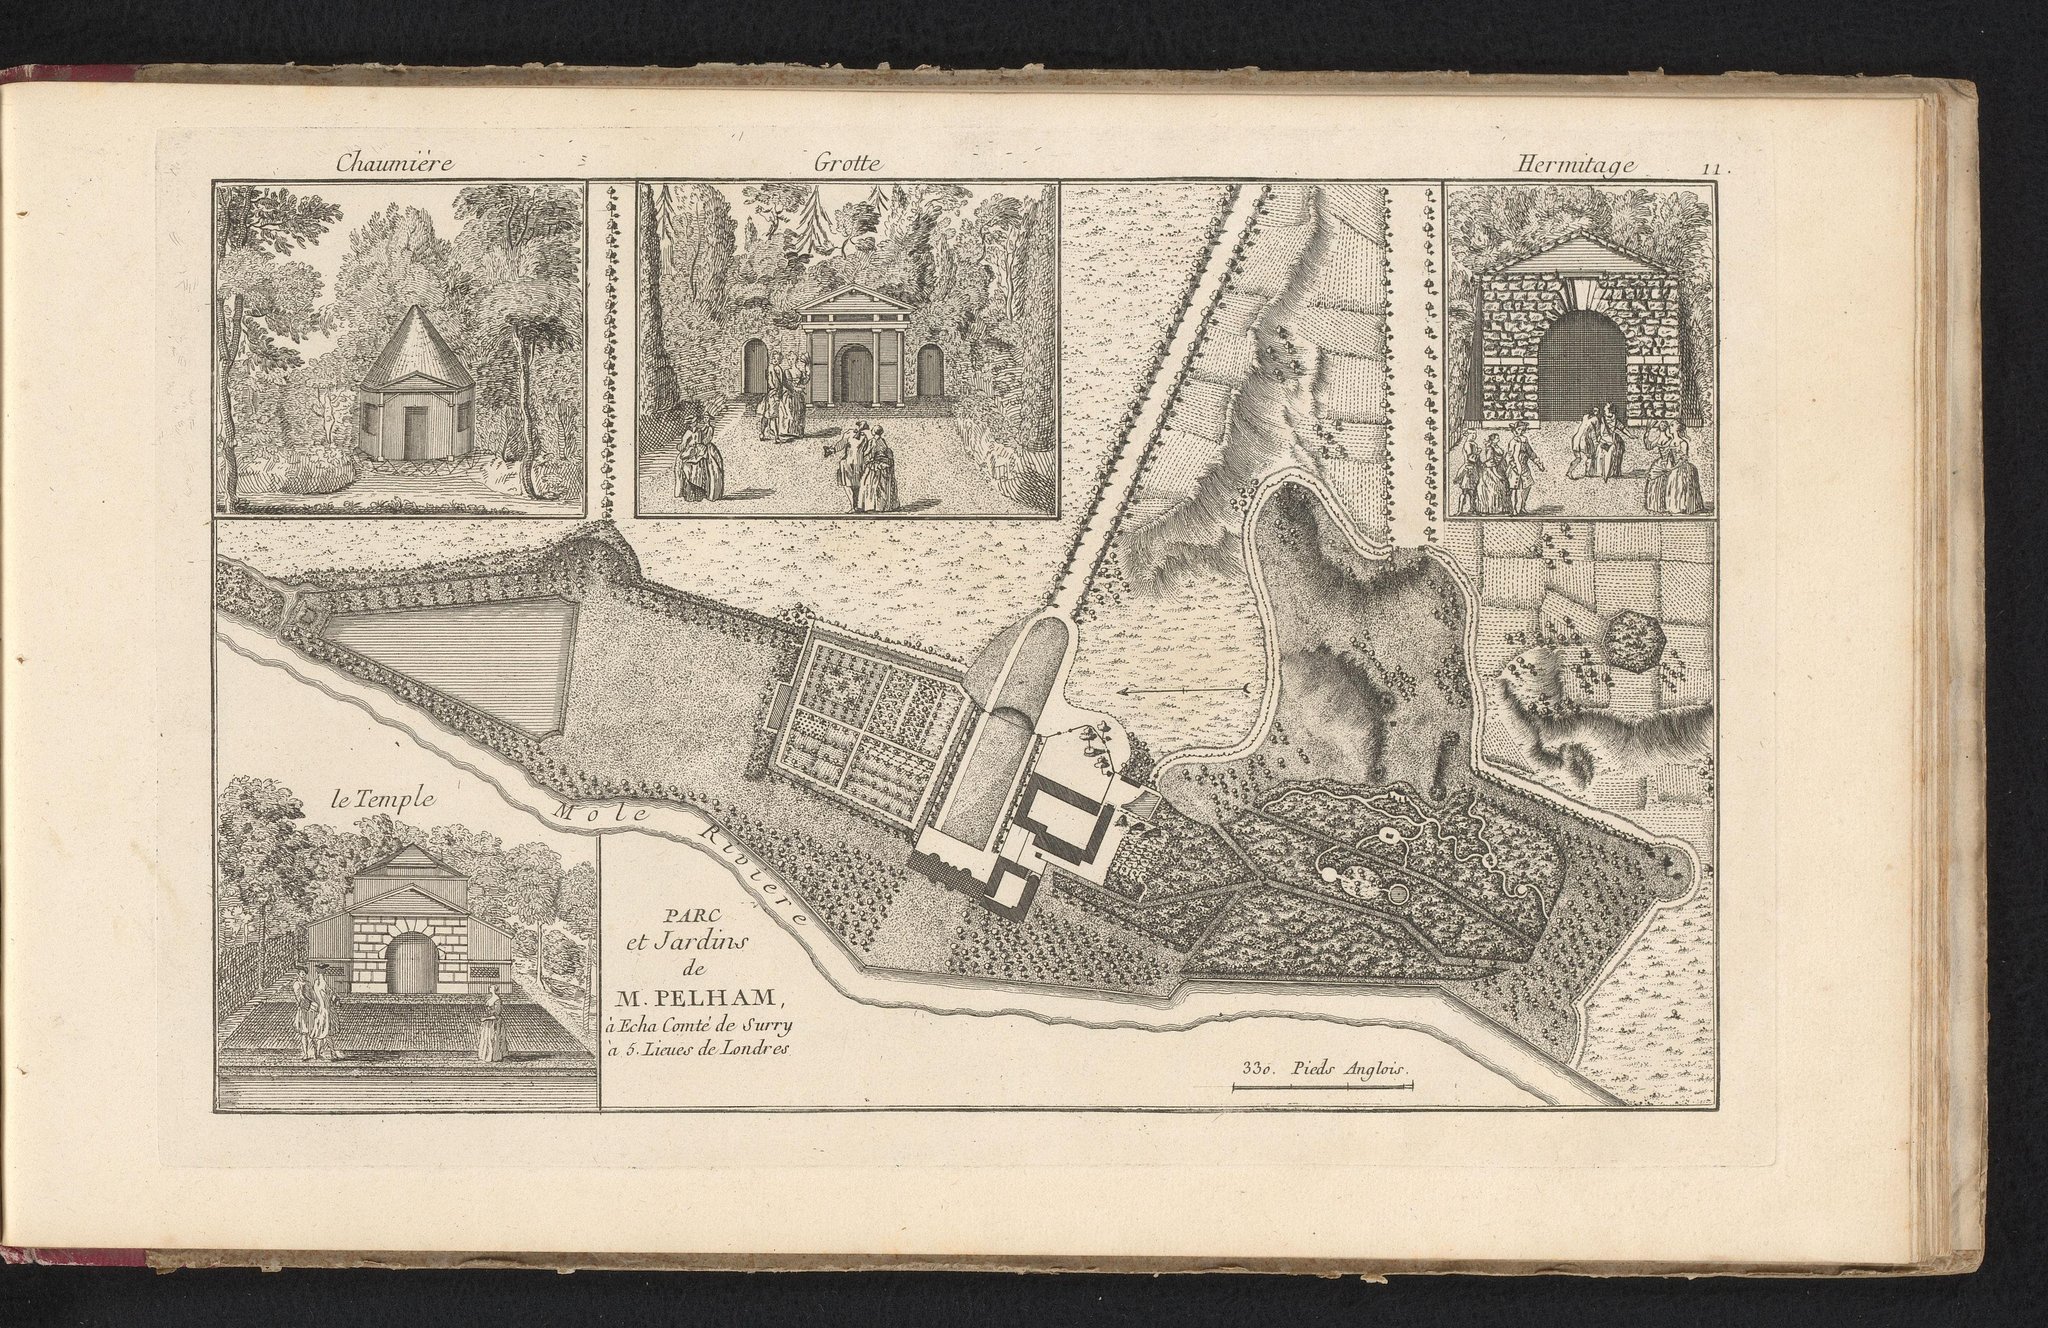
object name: album leaf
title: Plattegrond van de tuin bij Claremont House, met vier kleine gezichten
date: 1775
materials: paper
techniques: engraving, etching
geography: paris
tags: plan, map of garden, garden buildings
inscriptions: collector's mark: Lugt 2228, collector's mark: Lugt 2760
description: De serie 'Jardins anglo-chinois à la mode' verscheen in totaal in 21 zogeheten 'cahiers' (afleveringen). De huidige prent komt uit het tweede 'cahier'. Het Rijksmuseum Amsterdam bezit drie banden met daarin in totaal zes 'cahiers' van deze reeks. In de documentatie wordt verwezen naar een in de bibliotheek van het Rijksmuseum Amsterdam aanwezige facsimile van het complete werk.